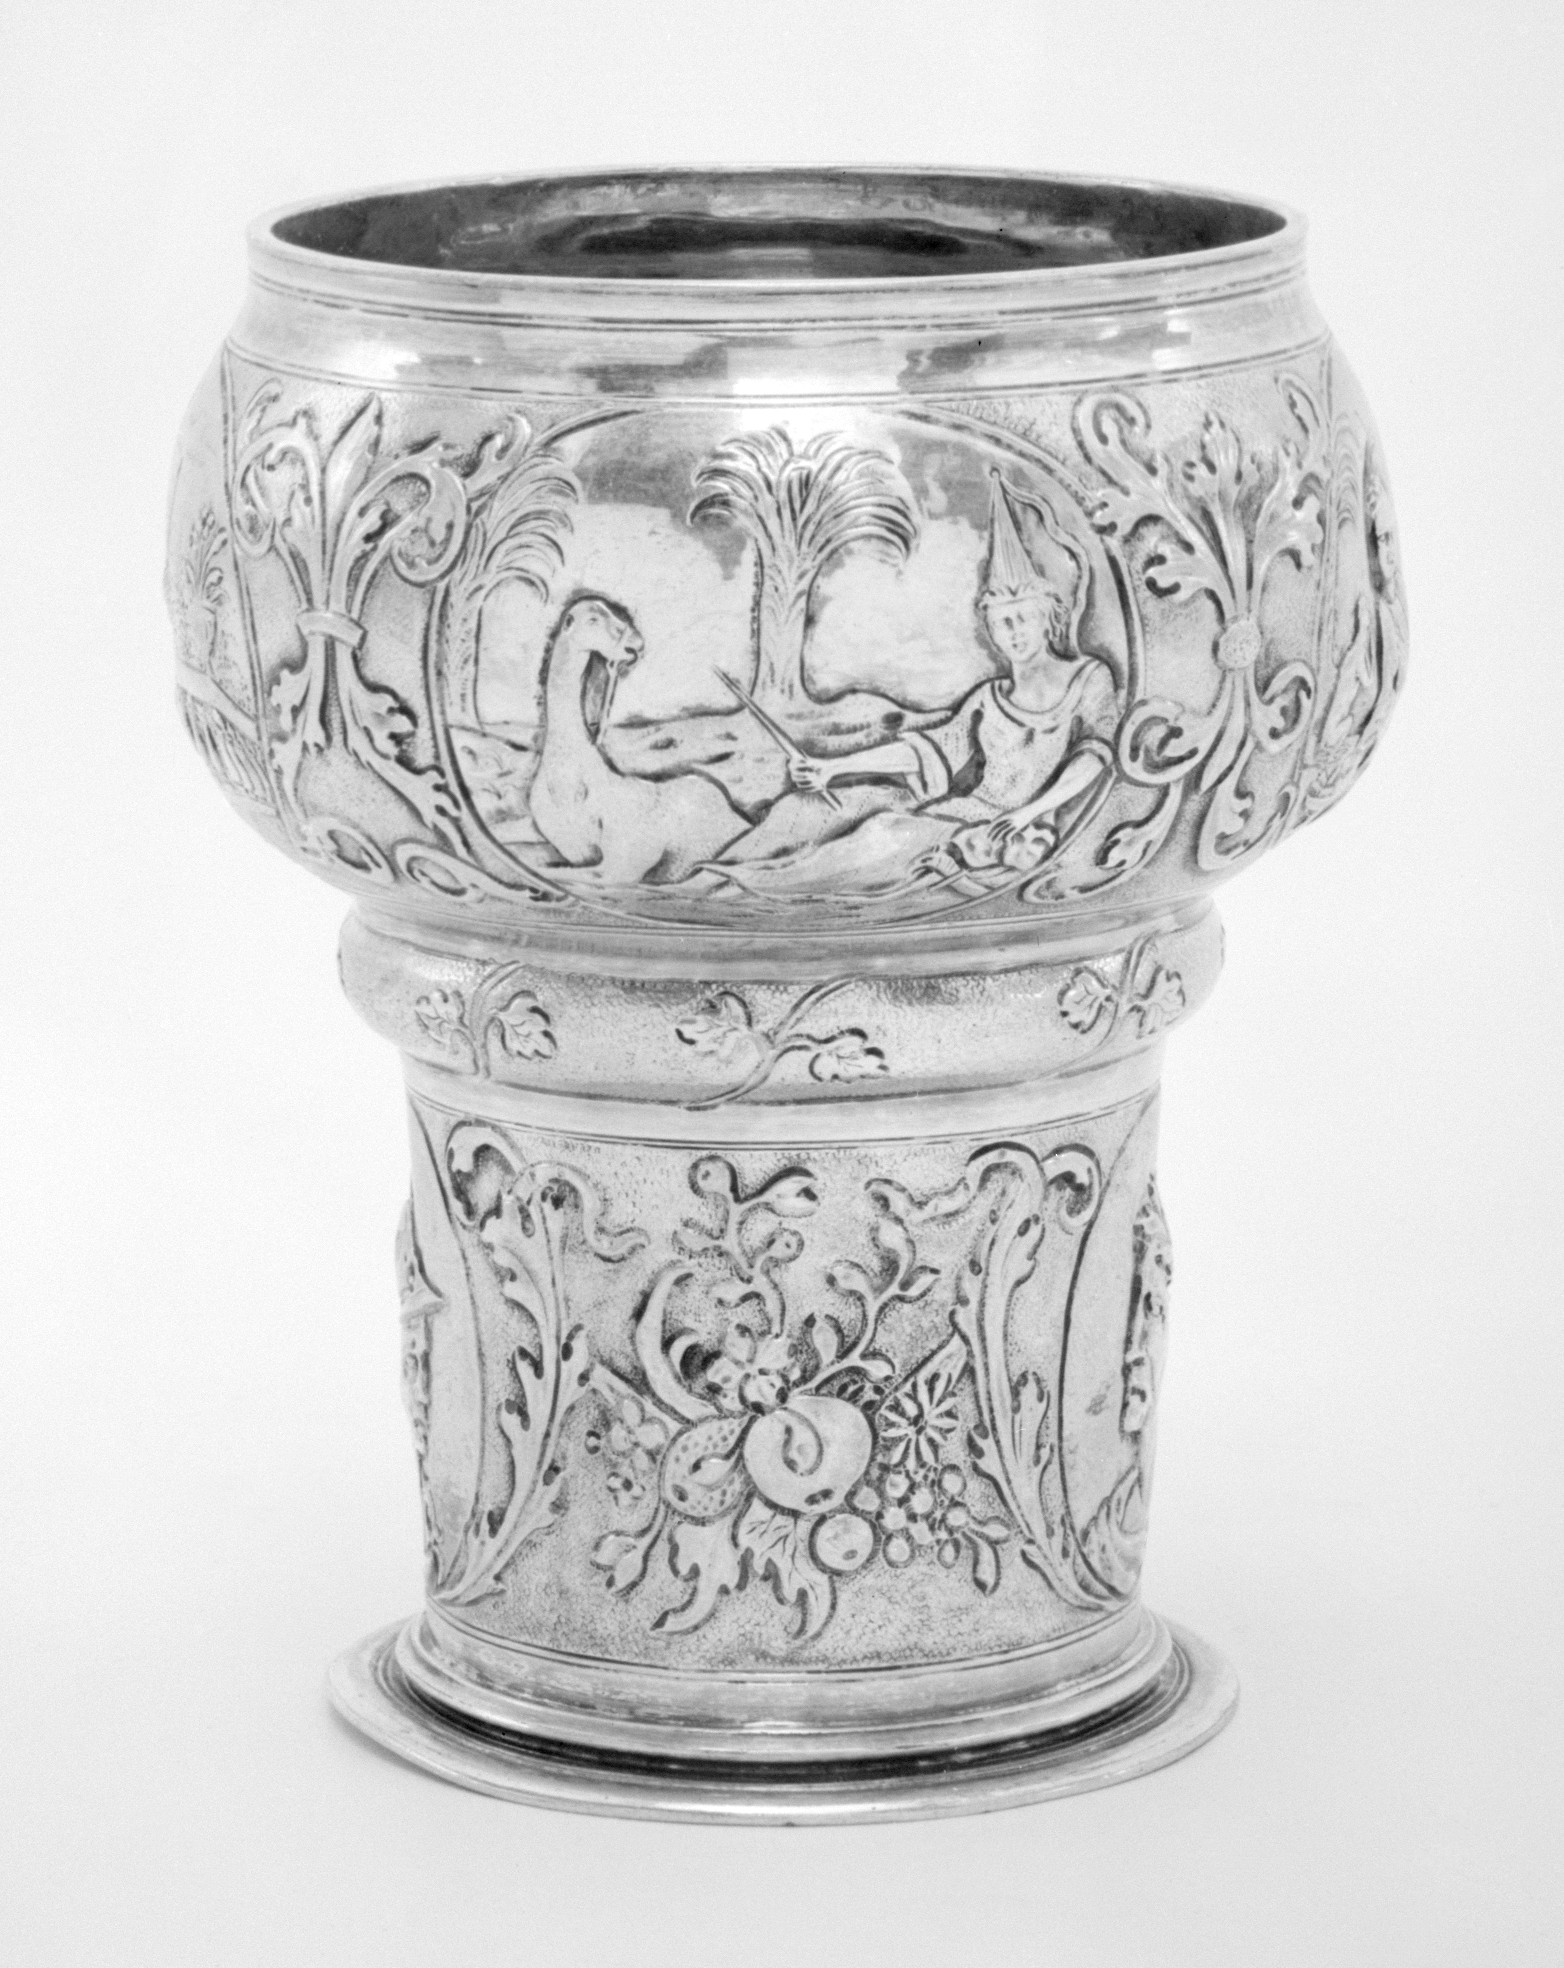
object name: cup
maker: p. s., augsburg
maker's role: maker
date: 1676-1700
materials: gilt, silver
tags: animals,men,trees